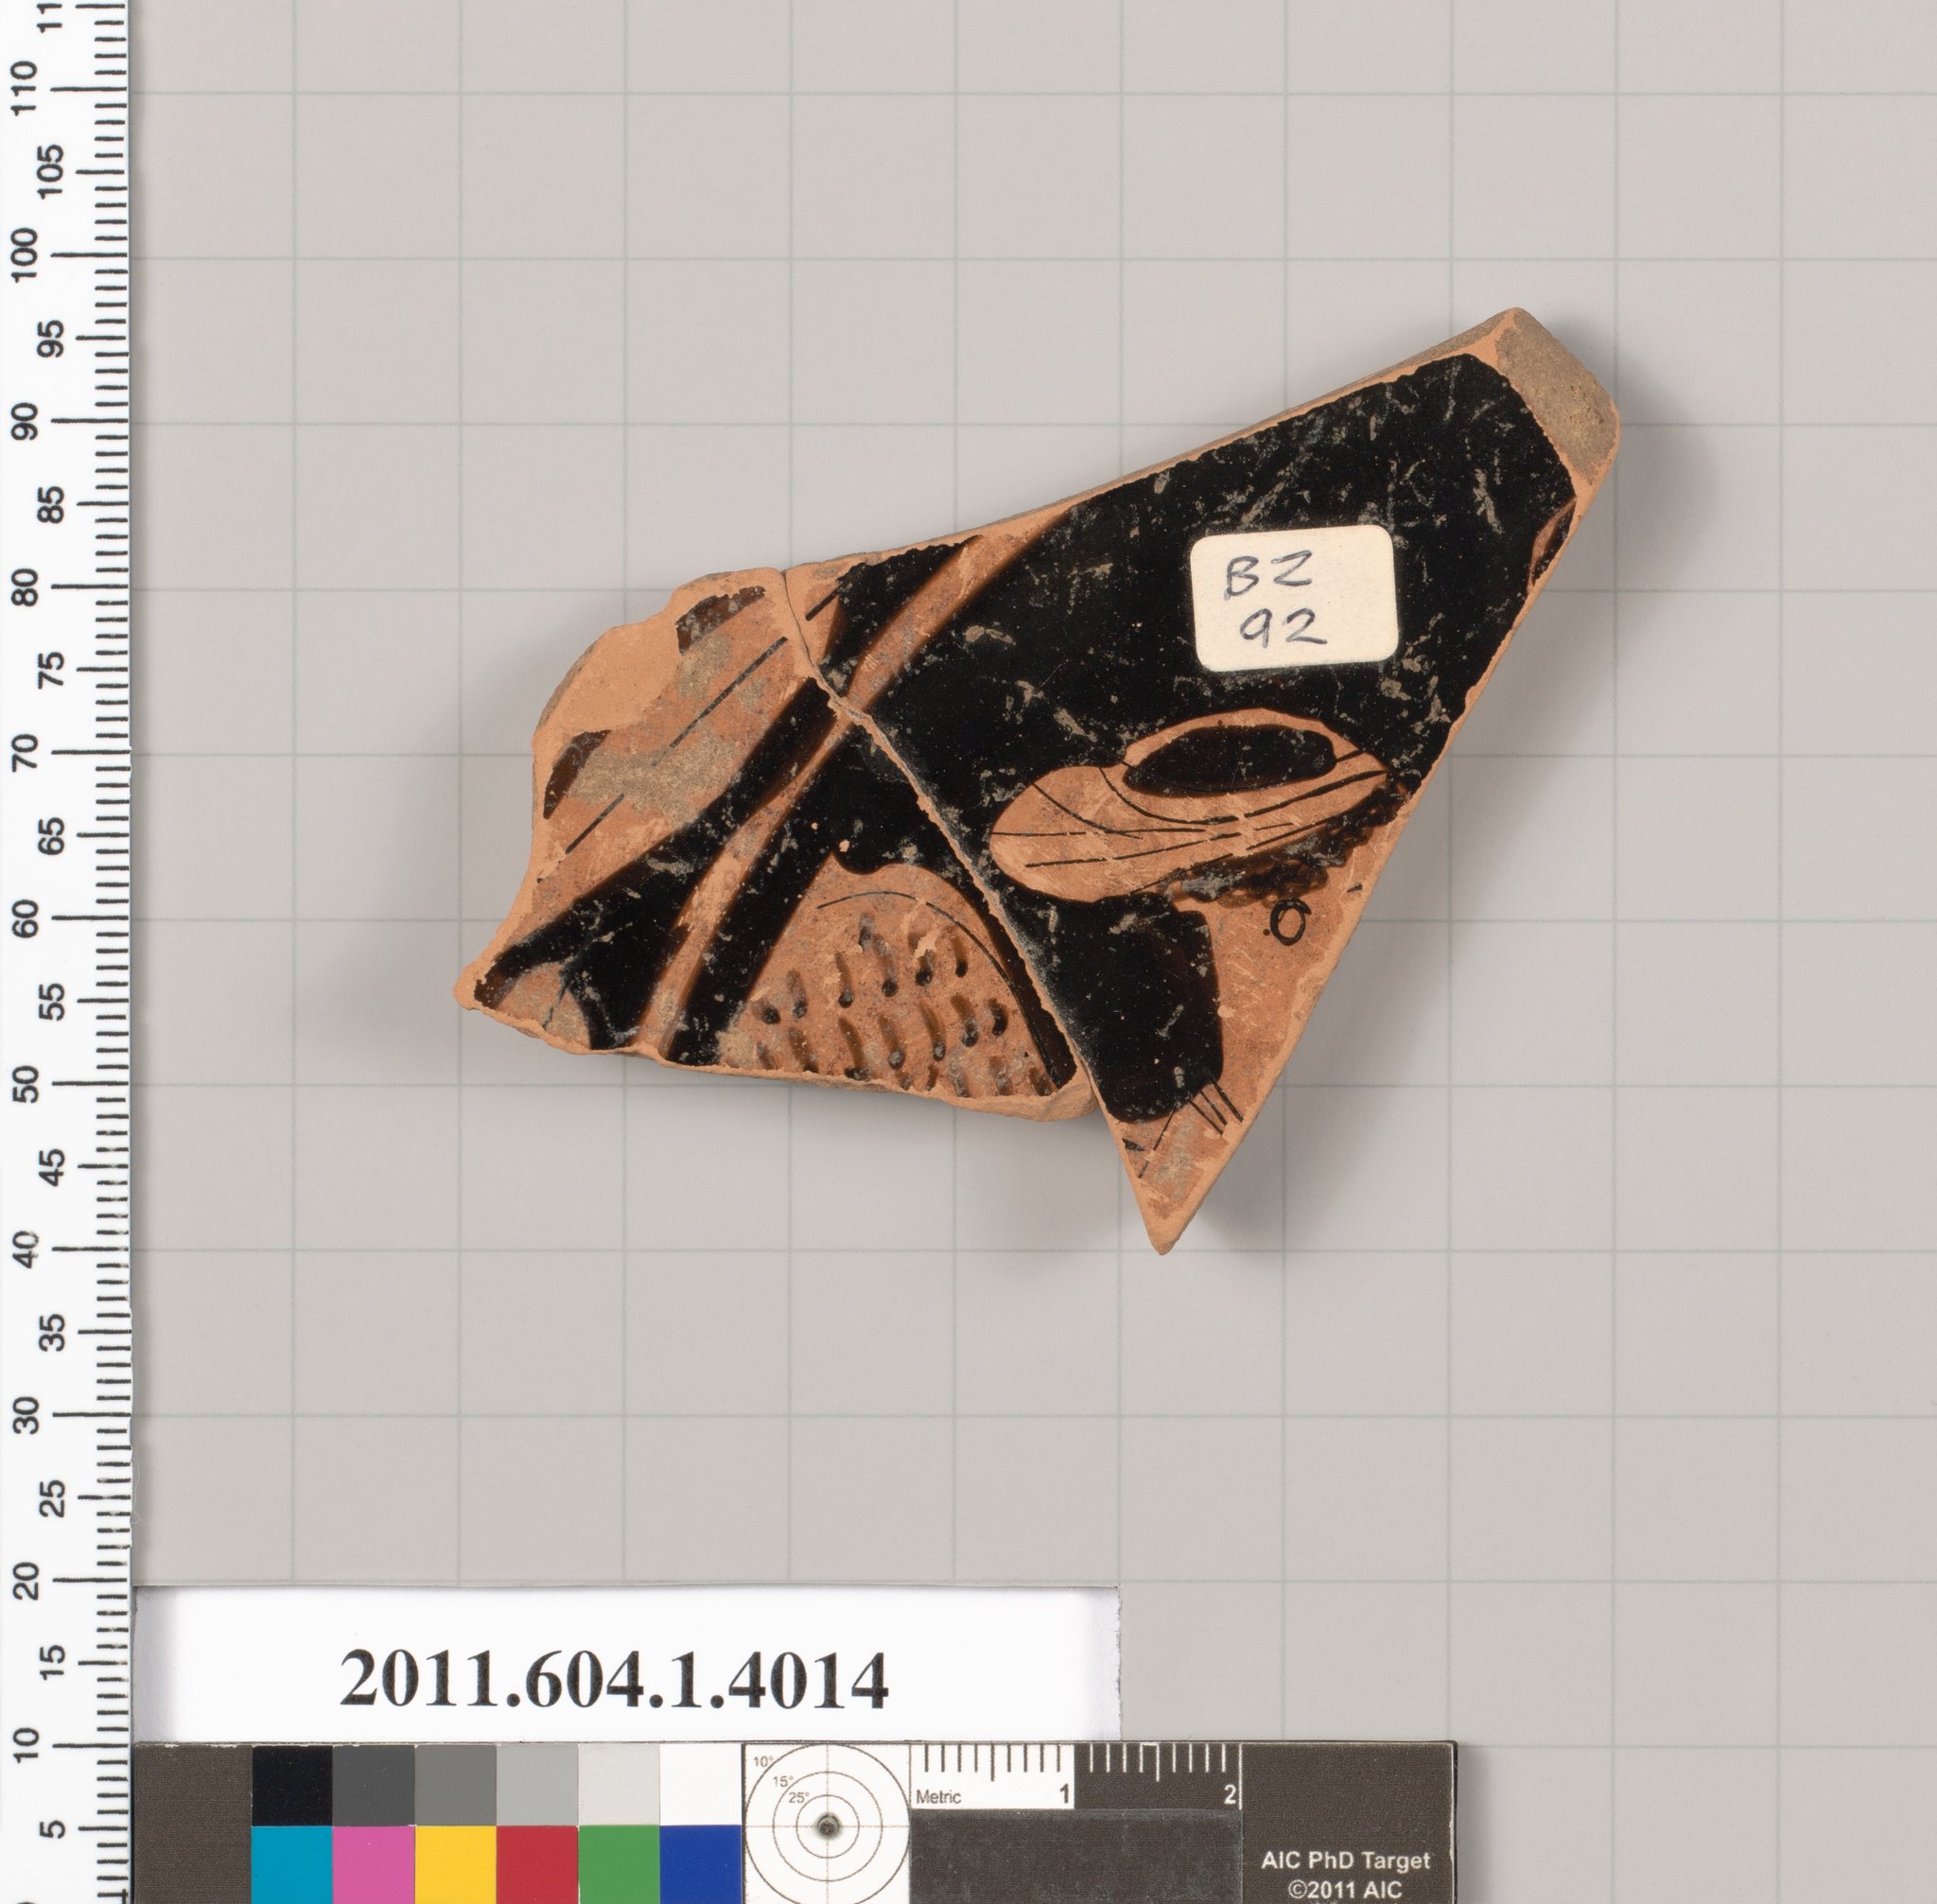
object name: kylix fragment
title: Terracotta fragment of a kylix (drinking cup)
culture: greek, attic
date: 460-440 BCE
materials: terracotta